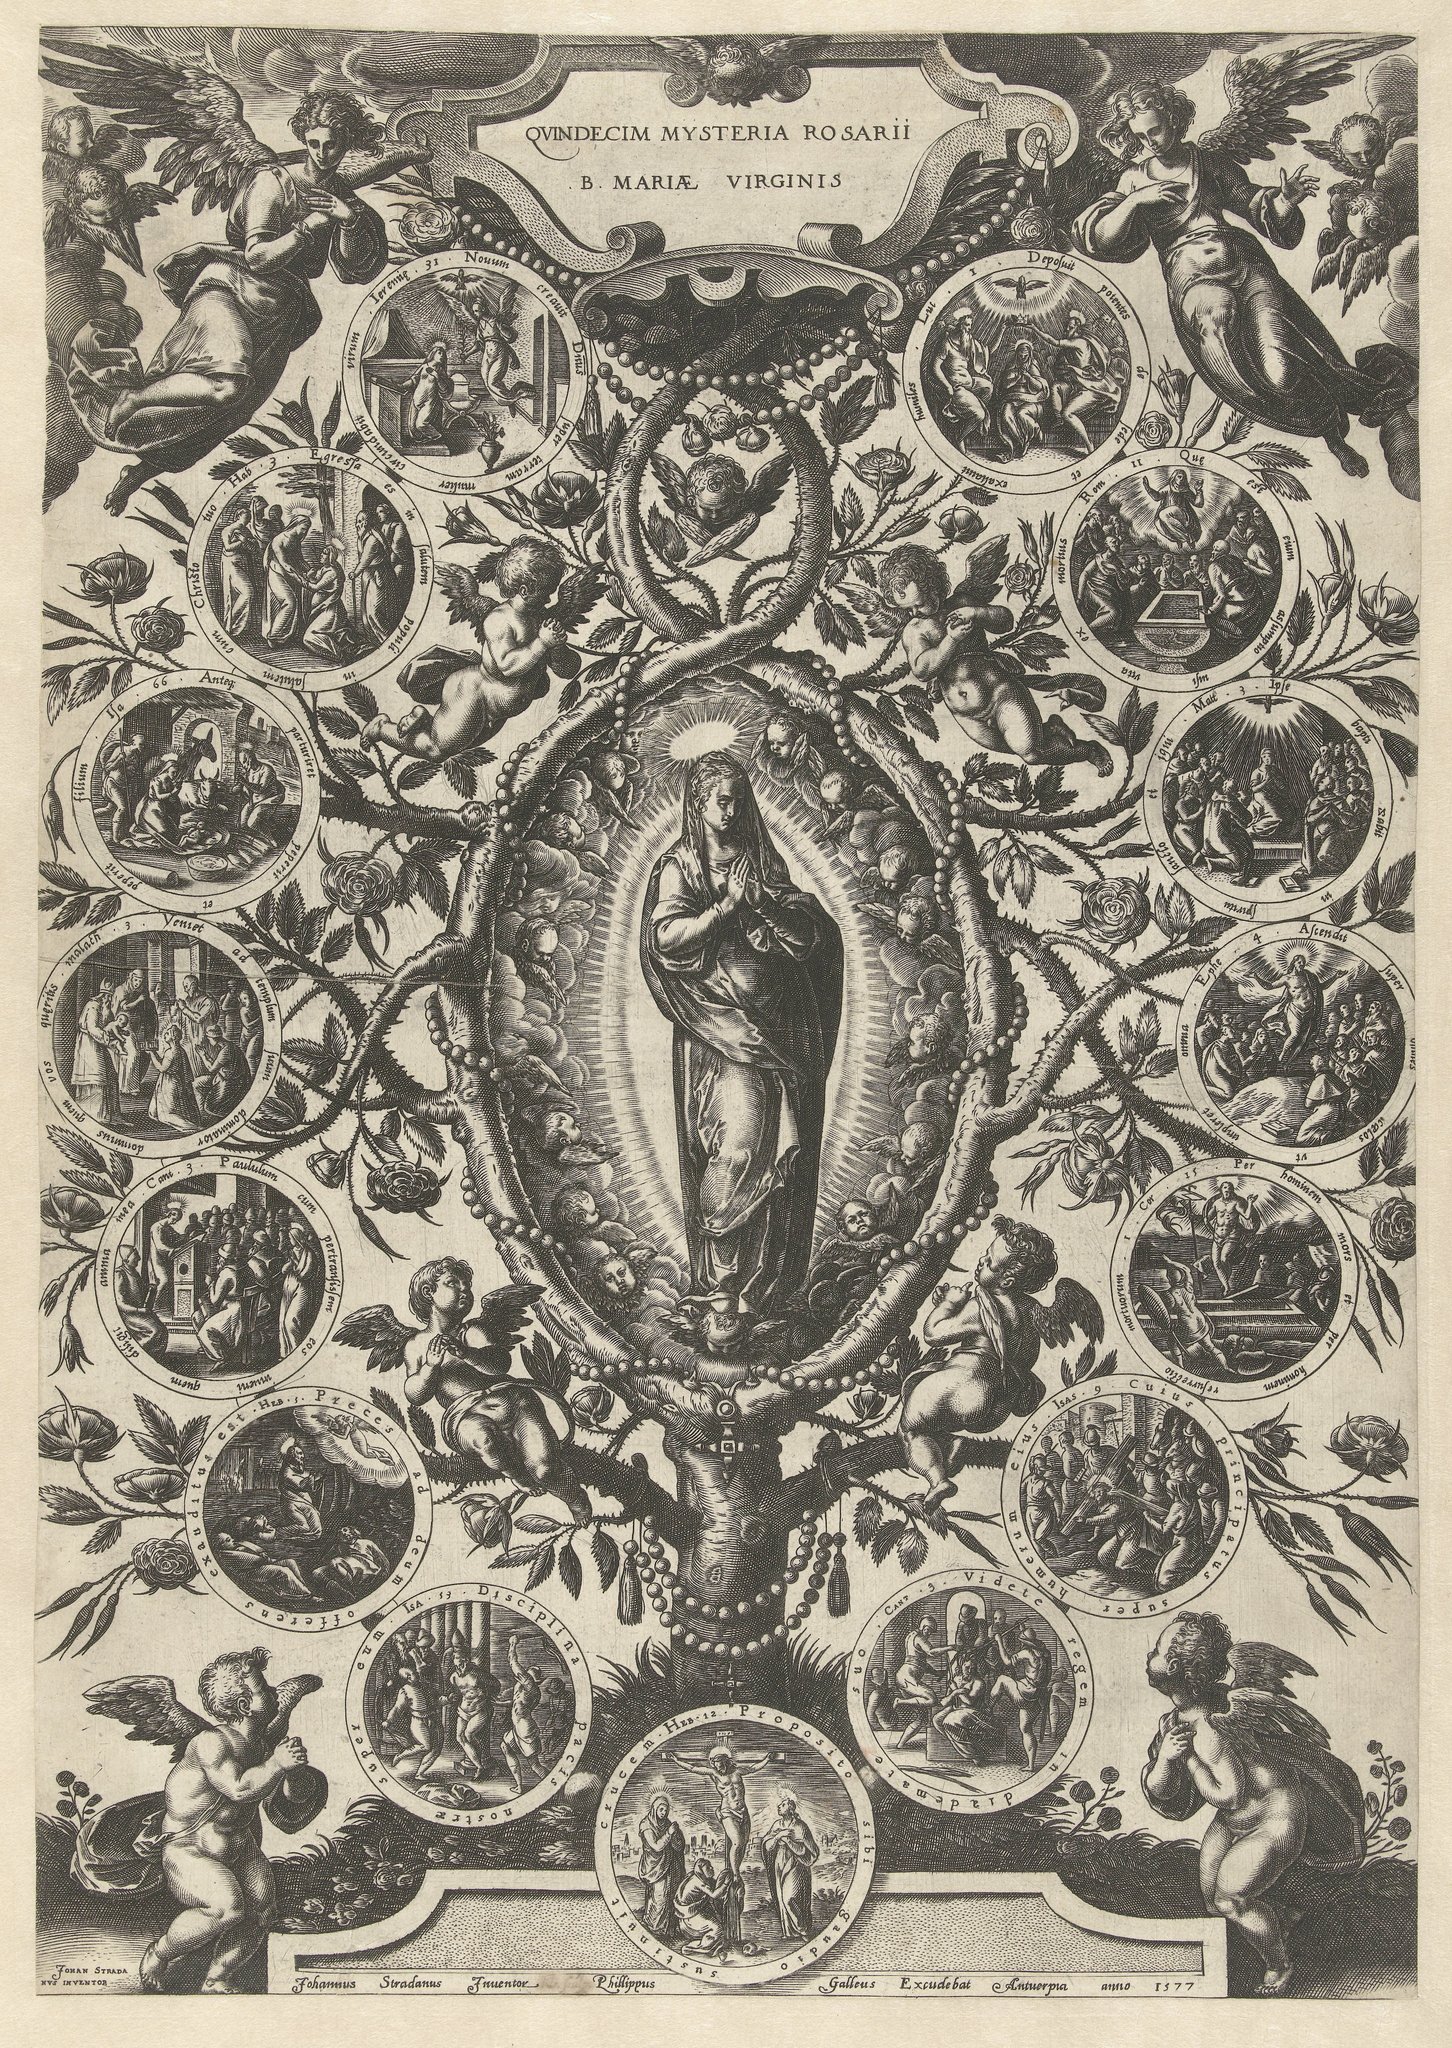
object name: print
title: Maria van de Rozenkrans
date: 1577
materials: paper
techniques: engraving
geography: antwerp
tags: 'marianum', madonna in aureole or mandorla (surrounded by the rosary), mary in the glory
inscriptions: collector's mark: Lugt 2228a, inscription: ‘HG sculp’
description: Maria, in mandorla, omgeven door cherubijnen en engelen, gevat in een rozenstruik. Aan de takken van de struik vijftien medaillons met voorstellingen uit het leven van Maria en Christus. Helemaal bovenin een cartouche met het opschrift.